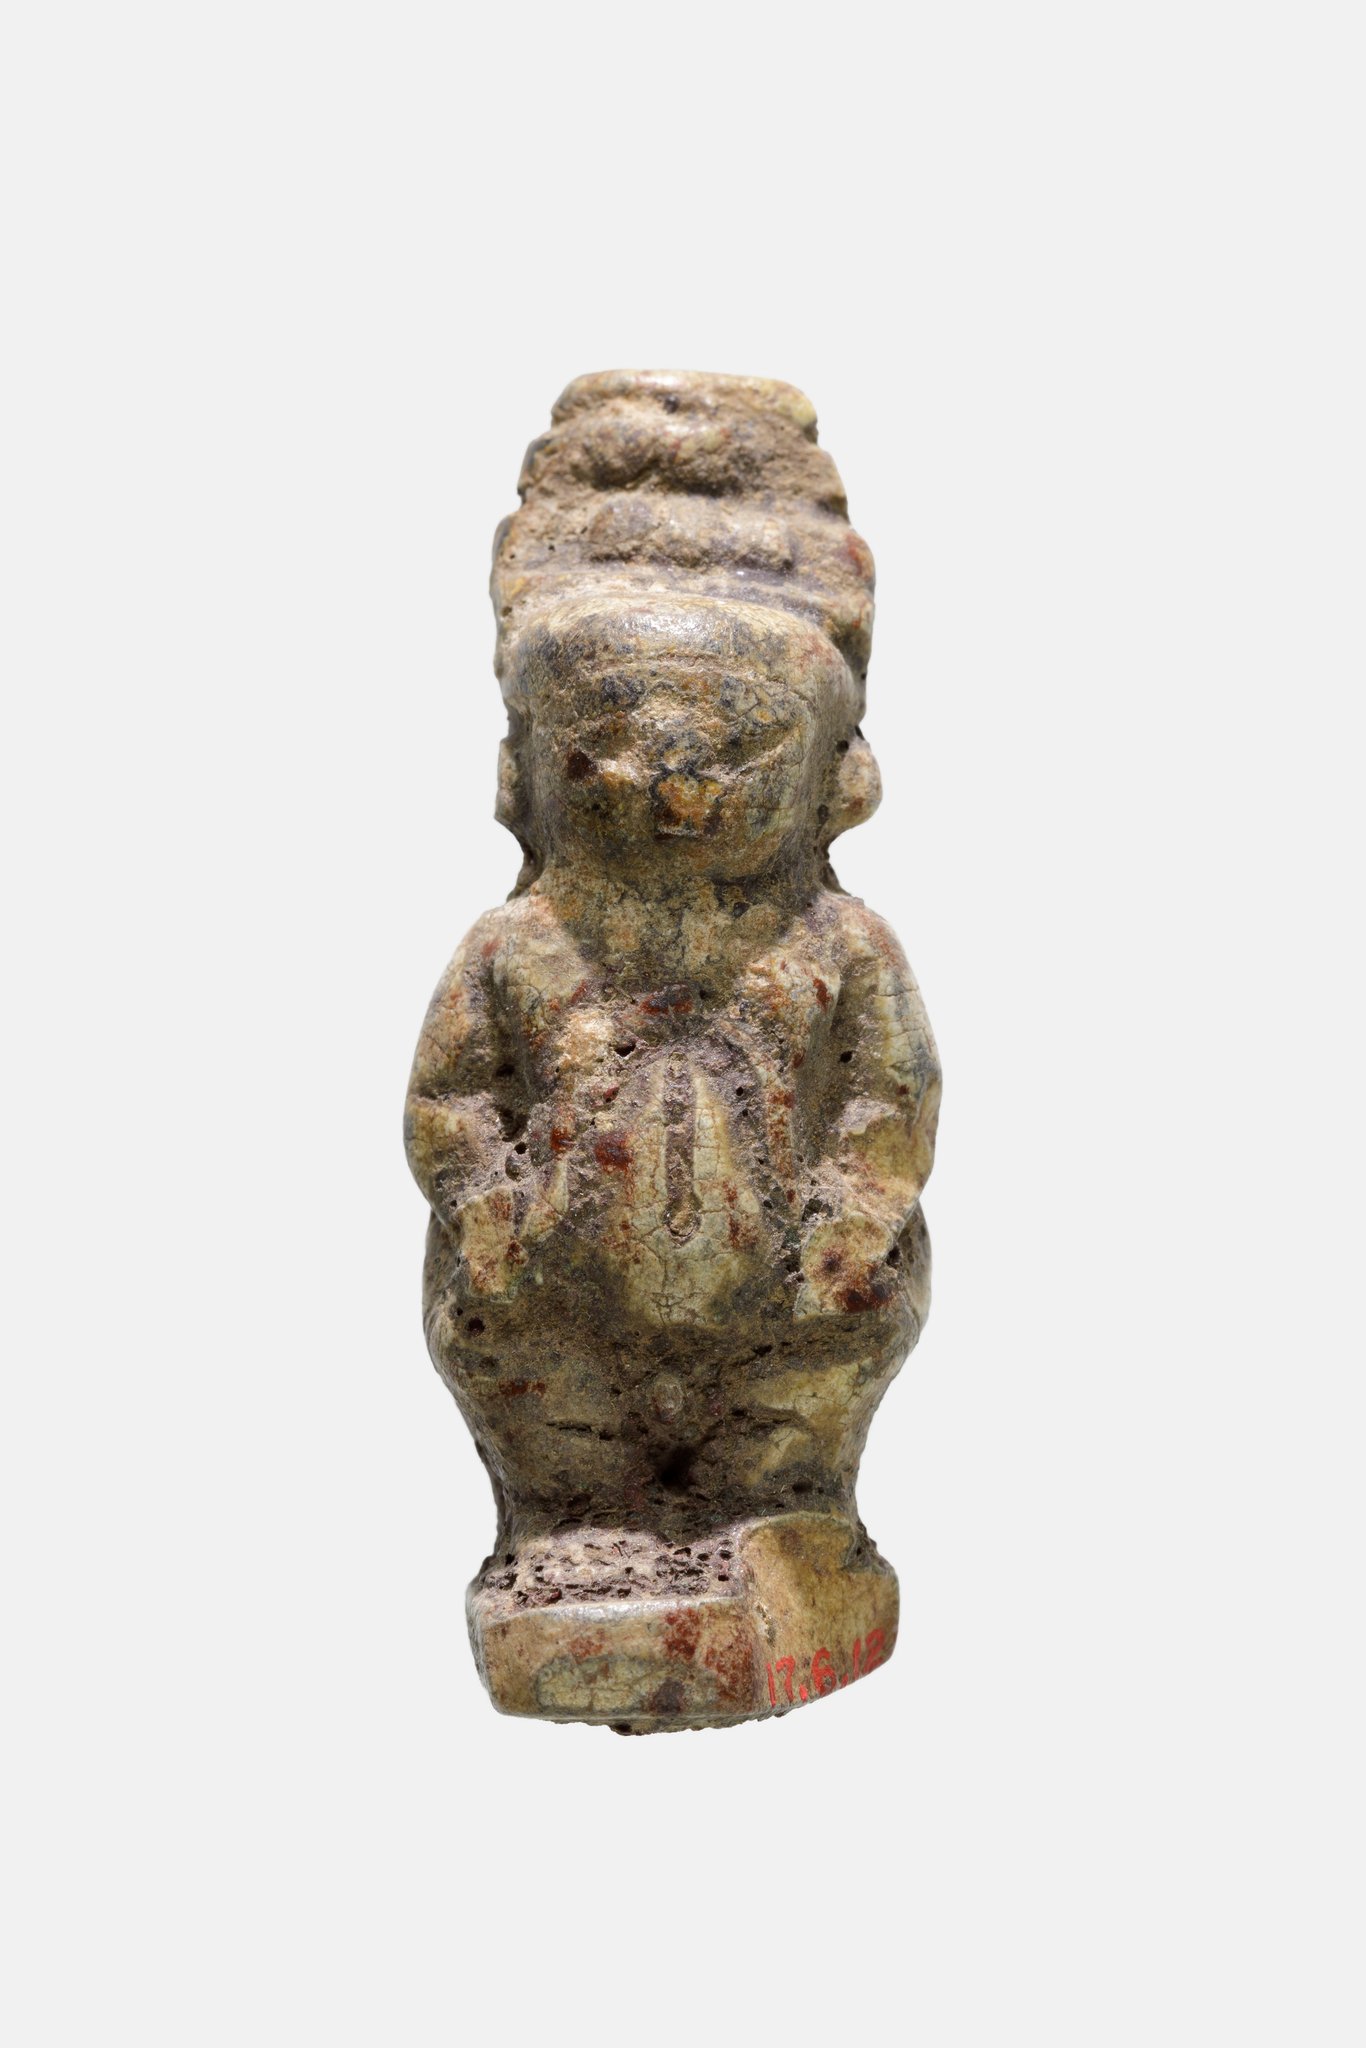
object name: amulet, ptah, with isi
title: Amulet of the Dwarf Ptah with Isis on the Back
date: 664-630 BCE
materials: faience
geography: northern upper egypt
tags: isis